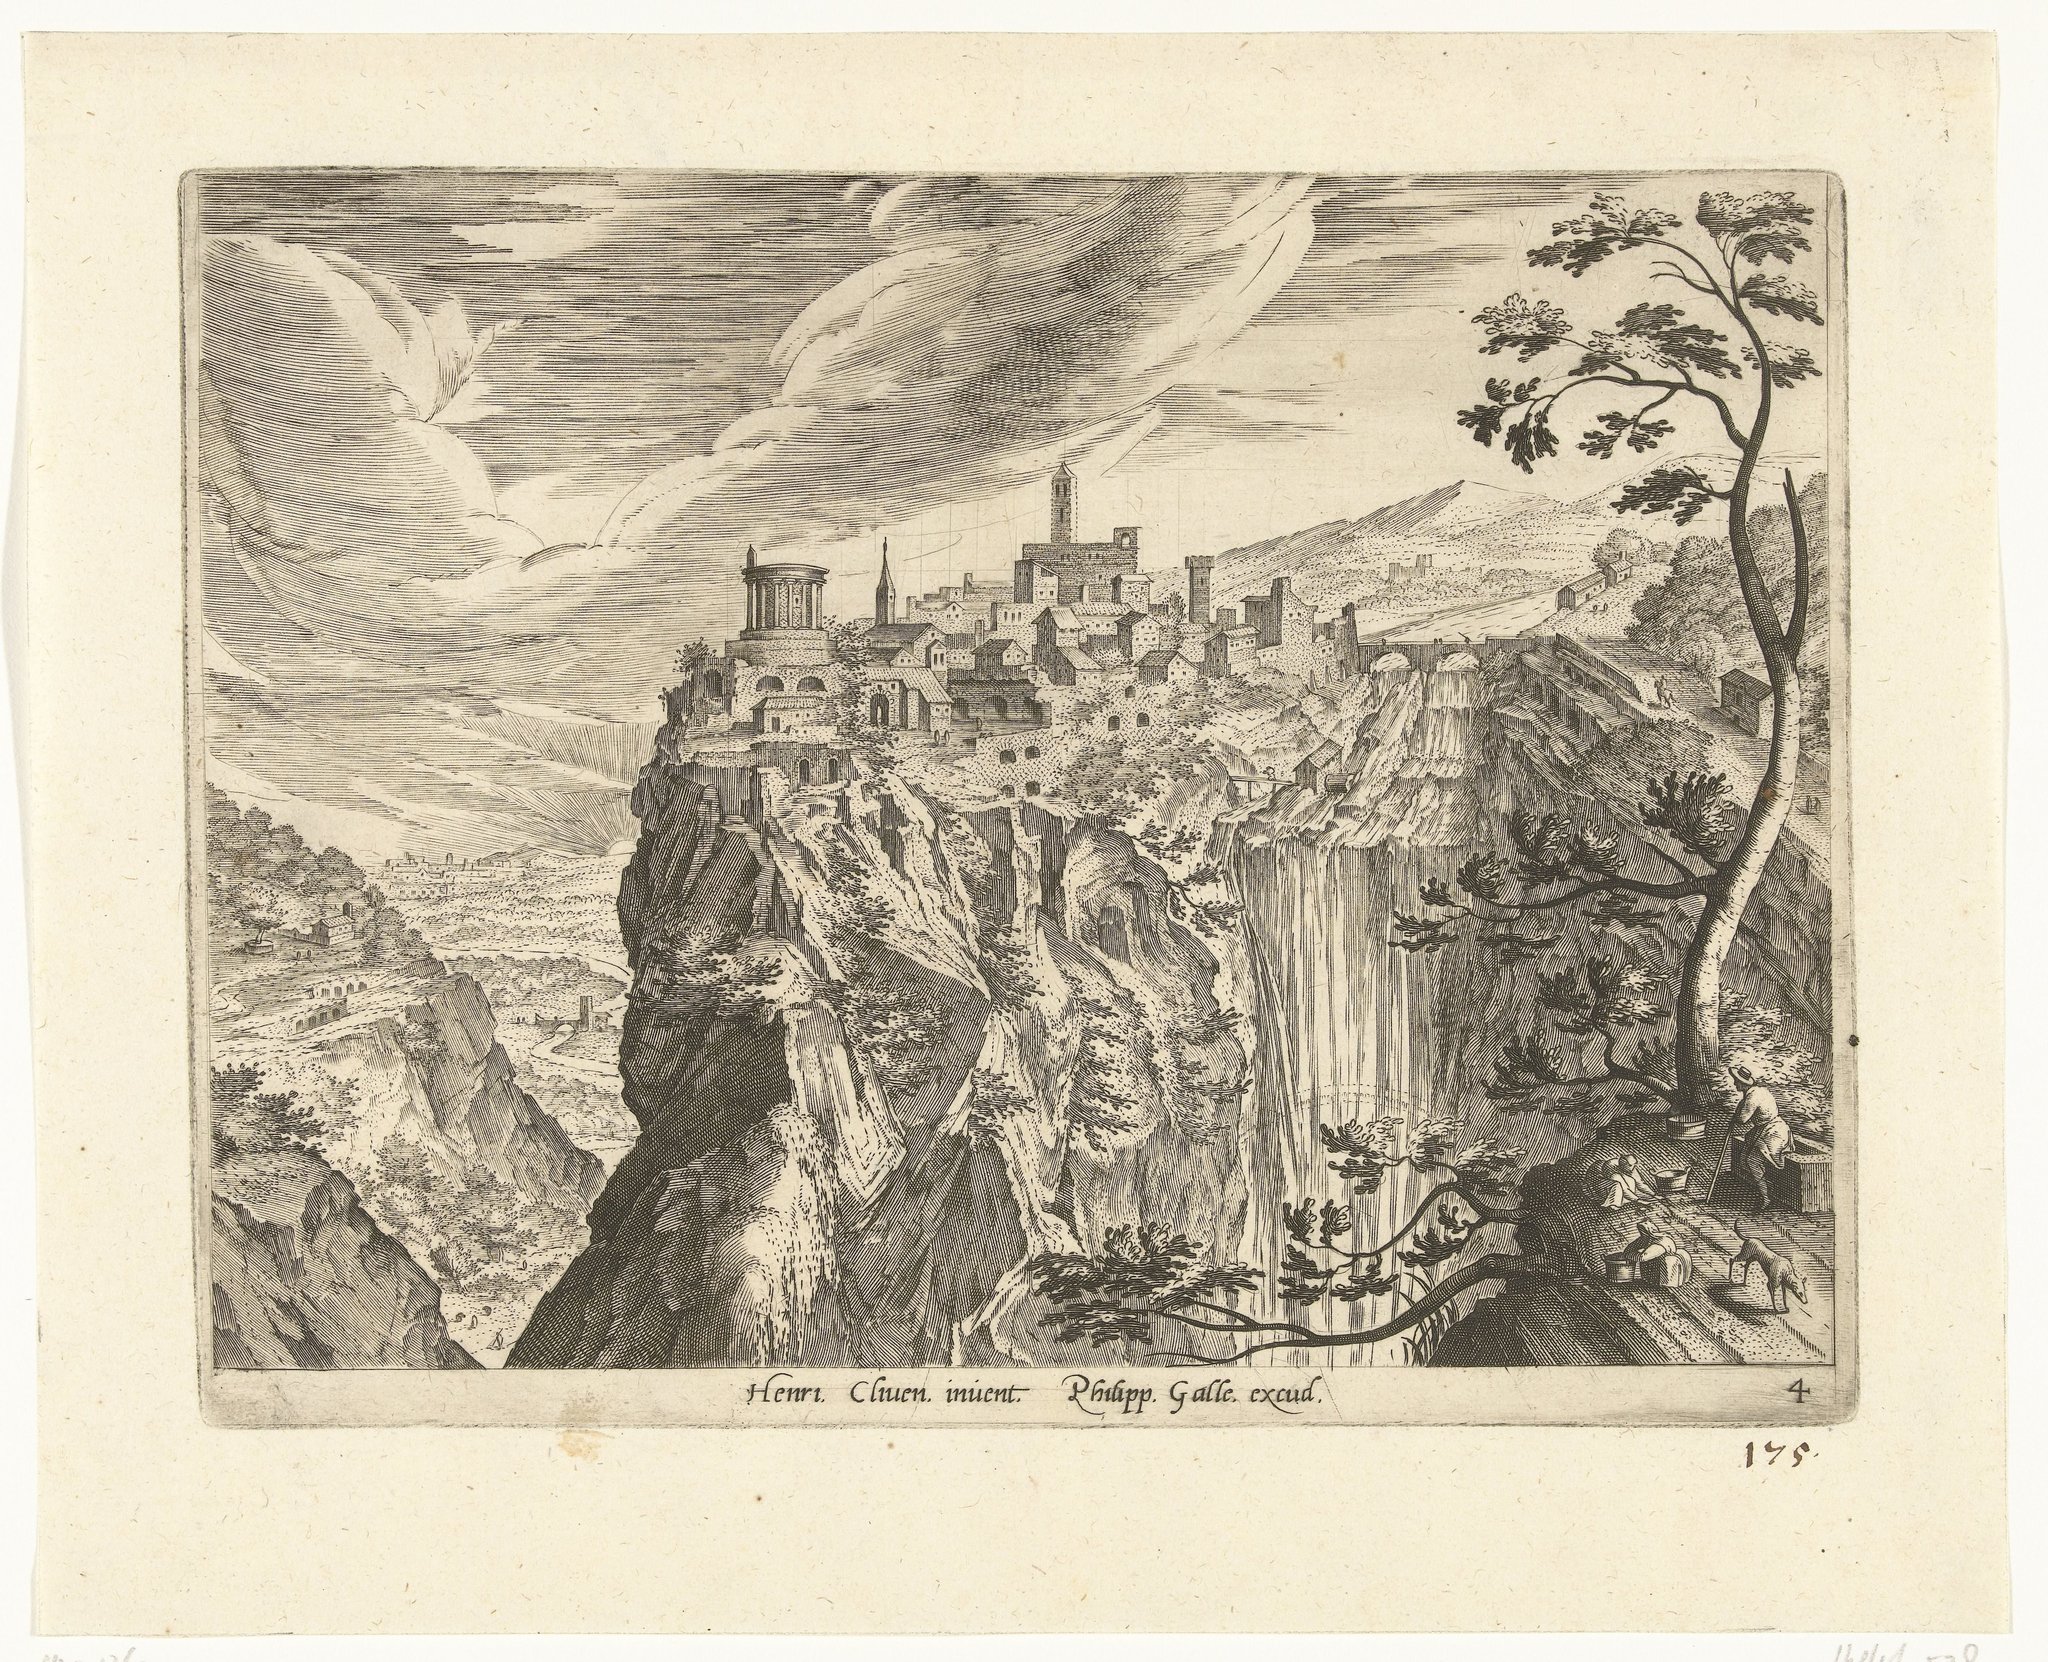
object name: print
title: Landschappen met ruïnes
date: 1587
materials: paper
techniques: engraving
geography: antwerp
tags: waterfall, landscape with ruins, tivoli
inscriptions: collector's mark: Lugt 2228, number: ‘175’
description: Gezicht op de watervallen van Tivoli alsook de antieke ruïnes van het stadje.De prent is deel van een tiendelige serie met landschappen met ruïnes.